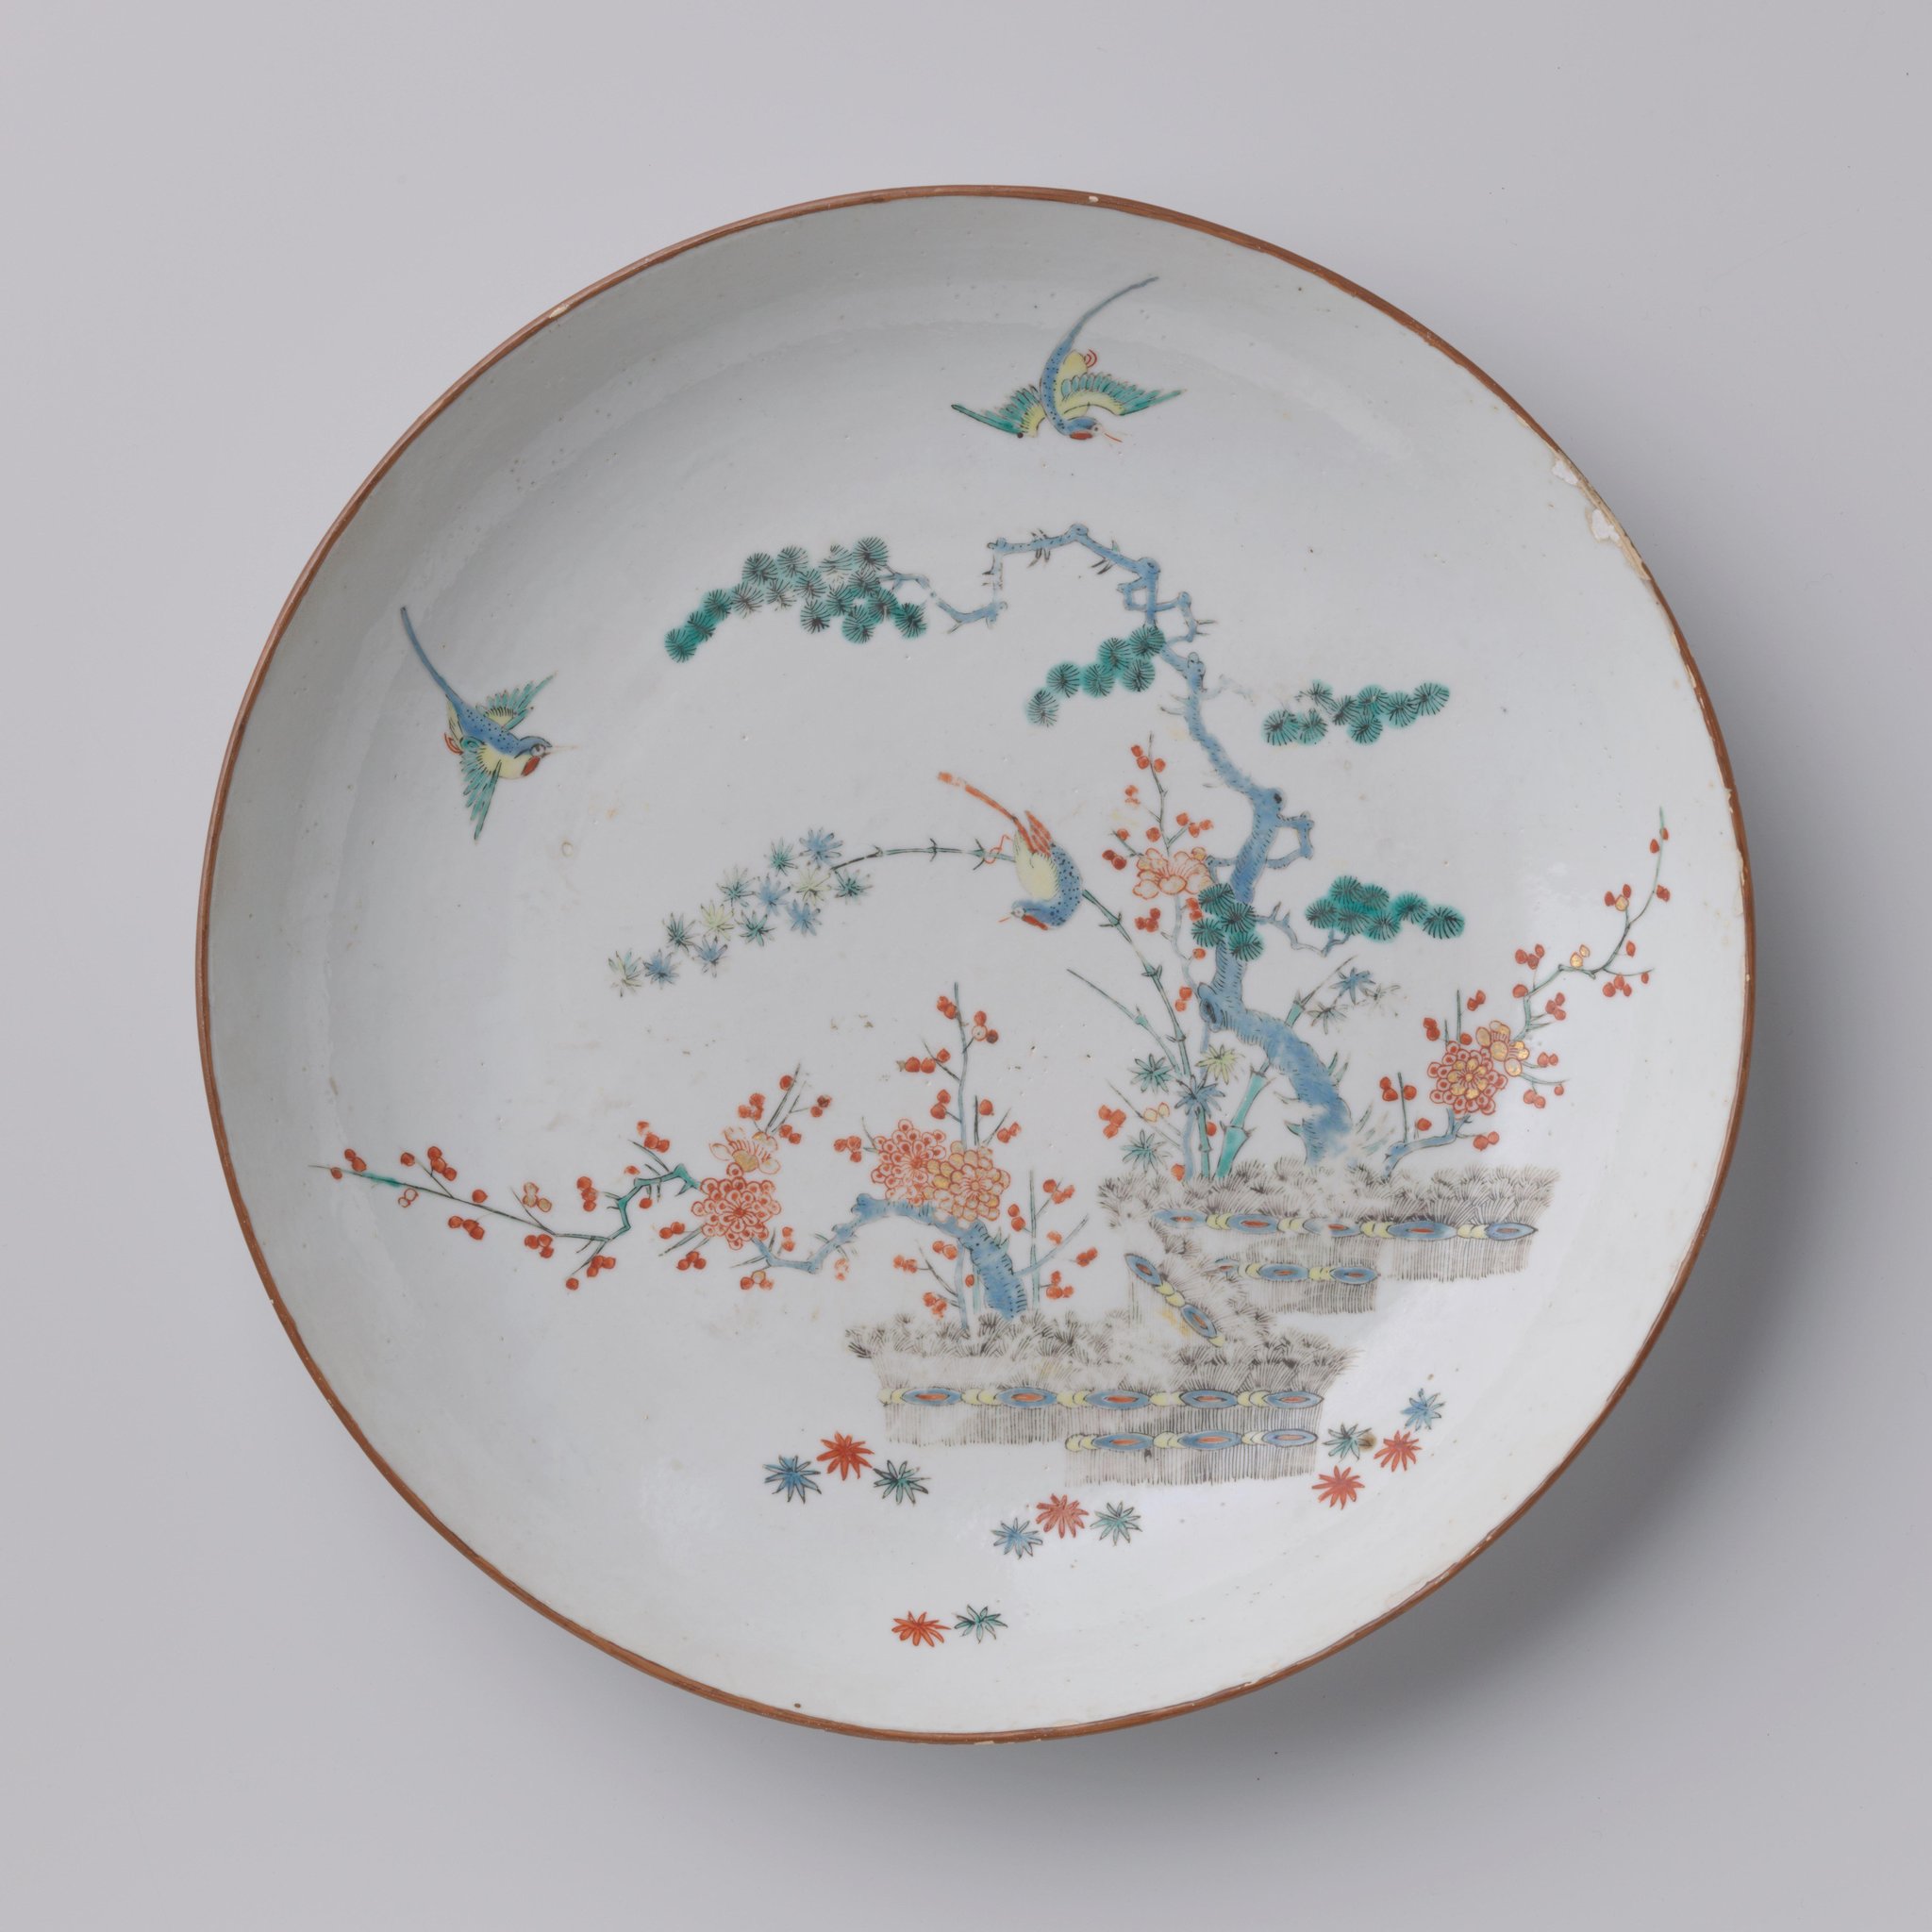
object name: platter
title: Dish with the 'three friends' and birds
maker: Anonymous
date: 1700-1724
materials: cobalt, glaze, gold, paint, porcelain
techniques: firing, gilding, turning, vitrification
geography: china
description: Schotel van porselein, beschilderd in onderglazuur blauw en op het glazuur in blauw, rood, groen, geel, zwart en goud. Op de voorzijde de 'drie vrienden van de winter' (bamboe, pijnboom, prunus) met daarbij drie vogels. Gemerkt op de onderzijde met een zegelmerk in een dubbele cirkel. Rand gerestaureerd. In Europa gedecoreerd in de Japanse Kakiemon-stijl.